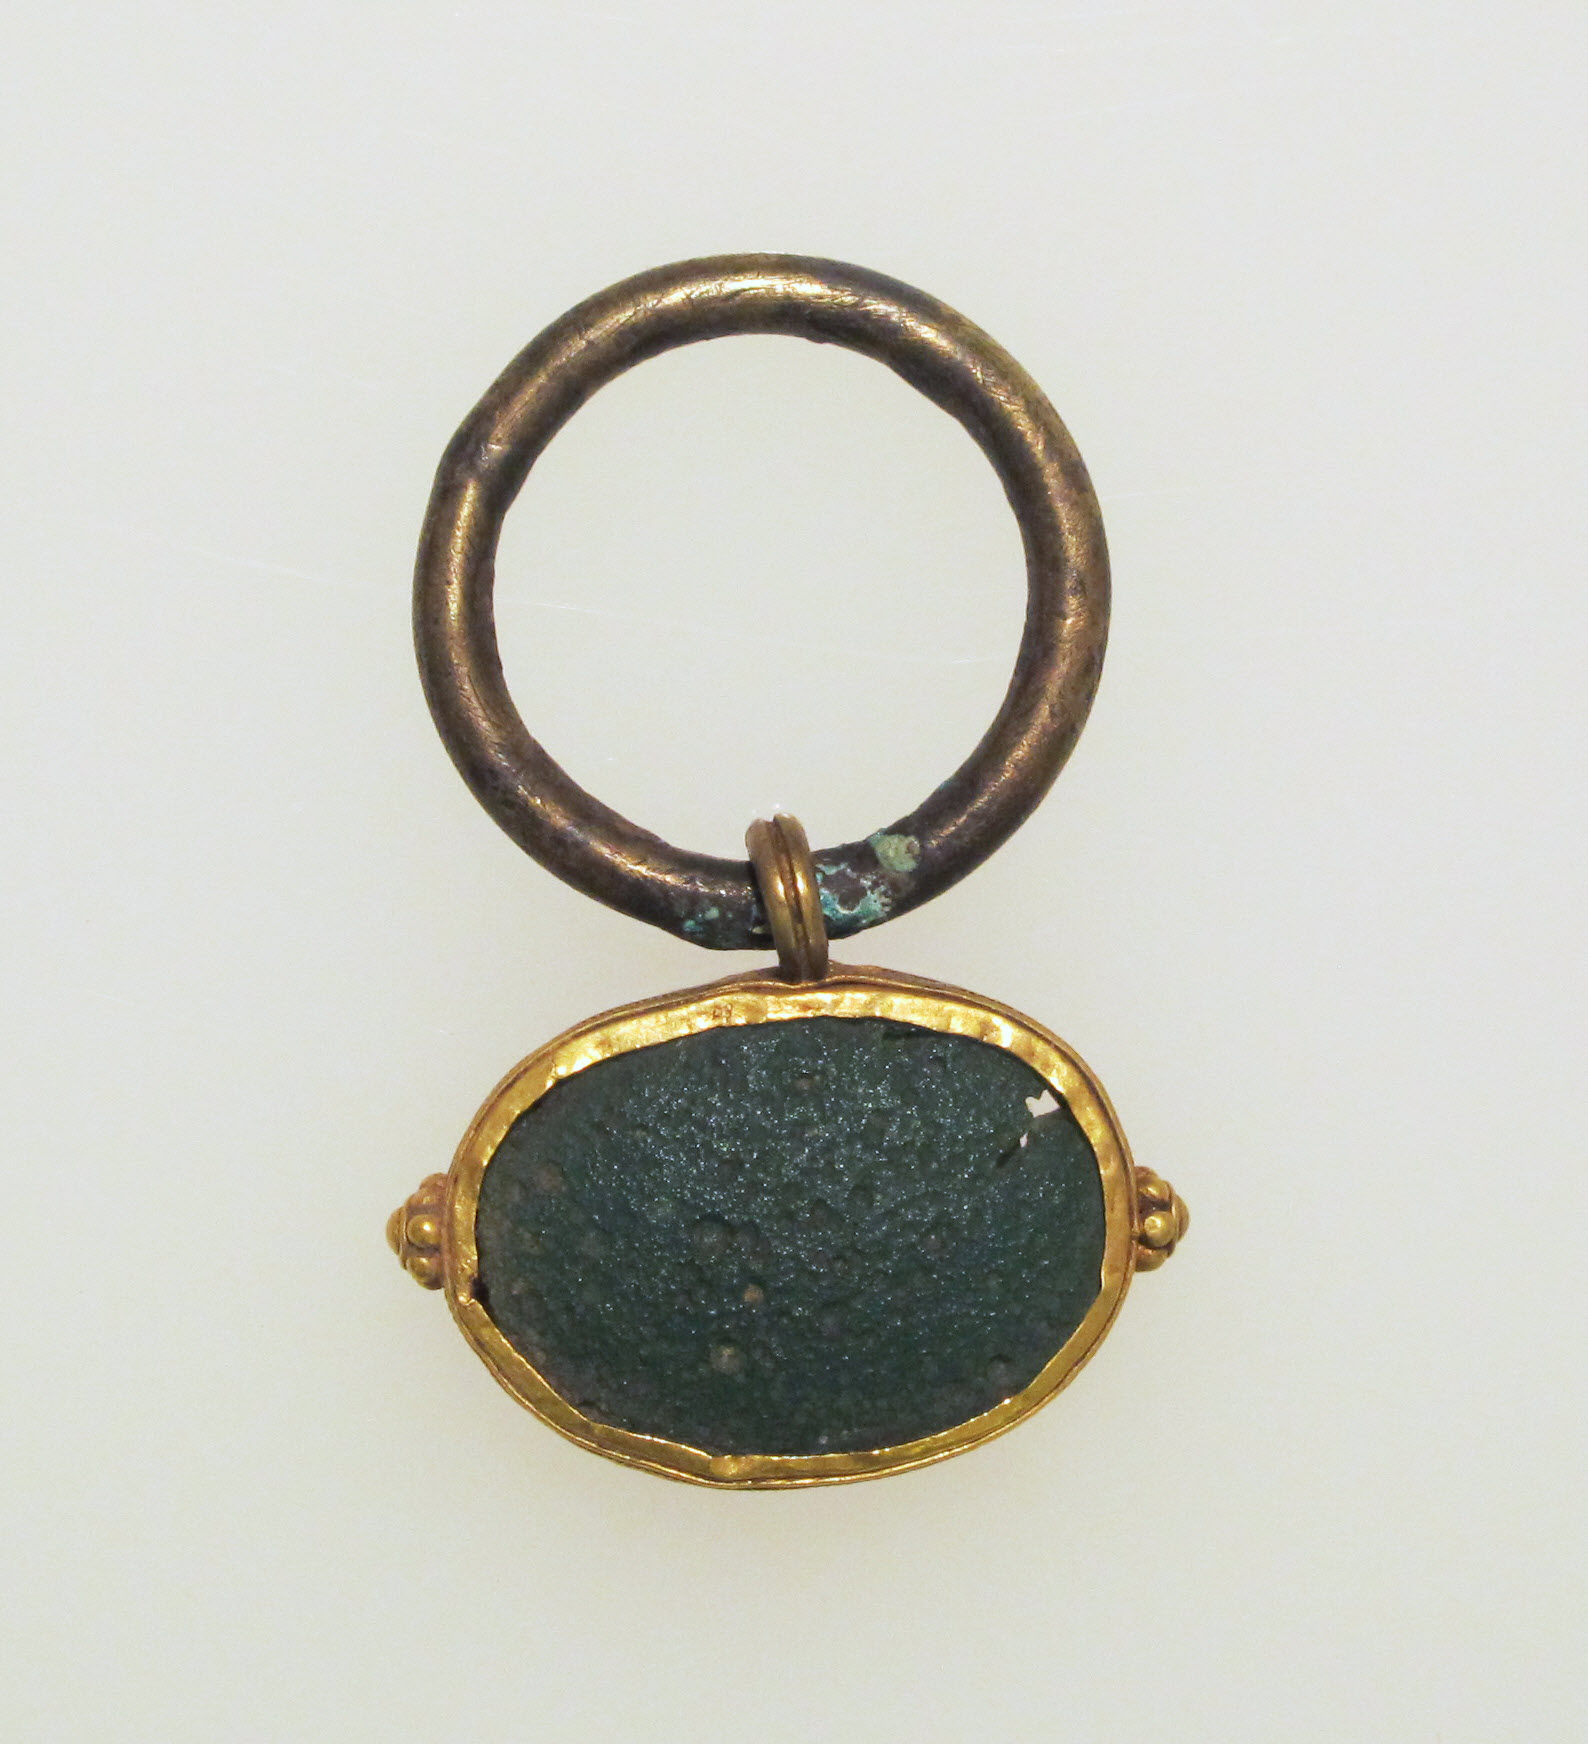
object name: ring with band setting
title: Ring with band settings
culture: roman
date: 100 BCE-300 CE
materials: glass, paste, silver